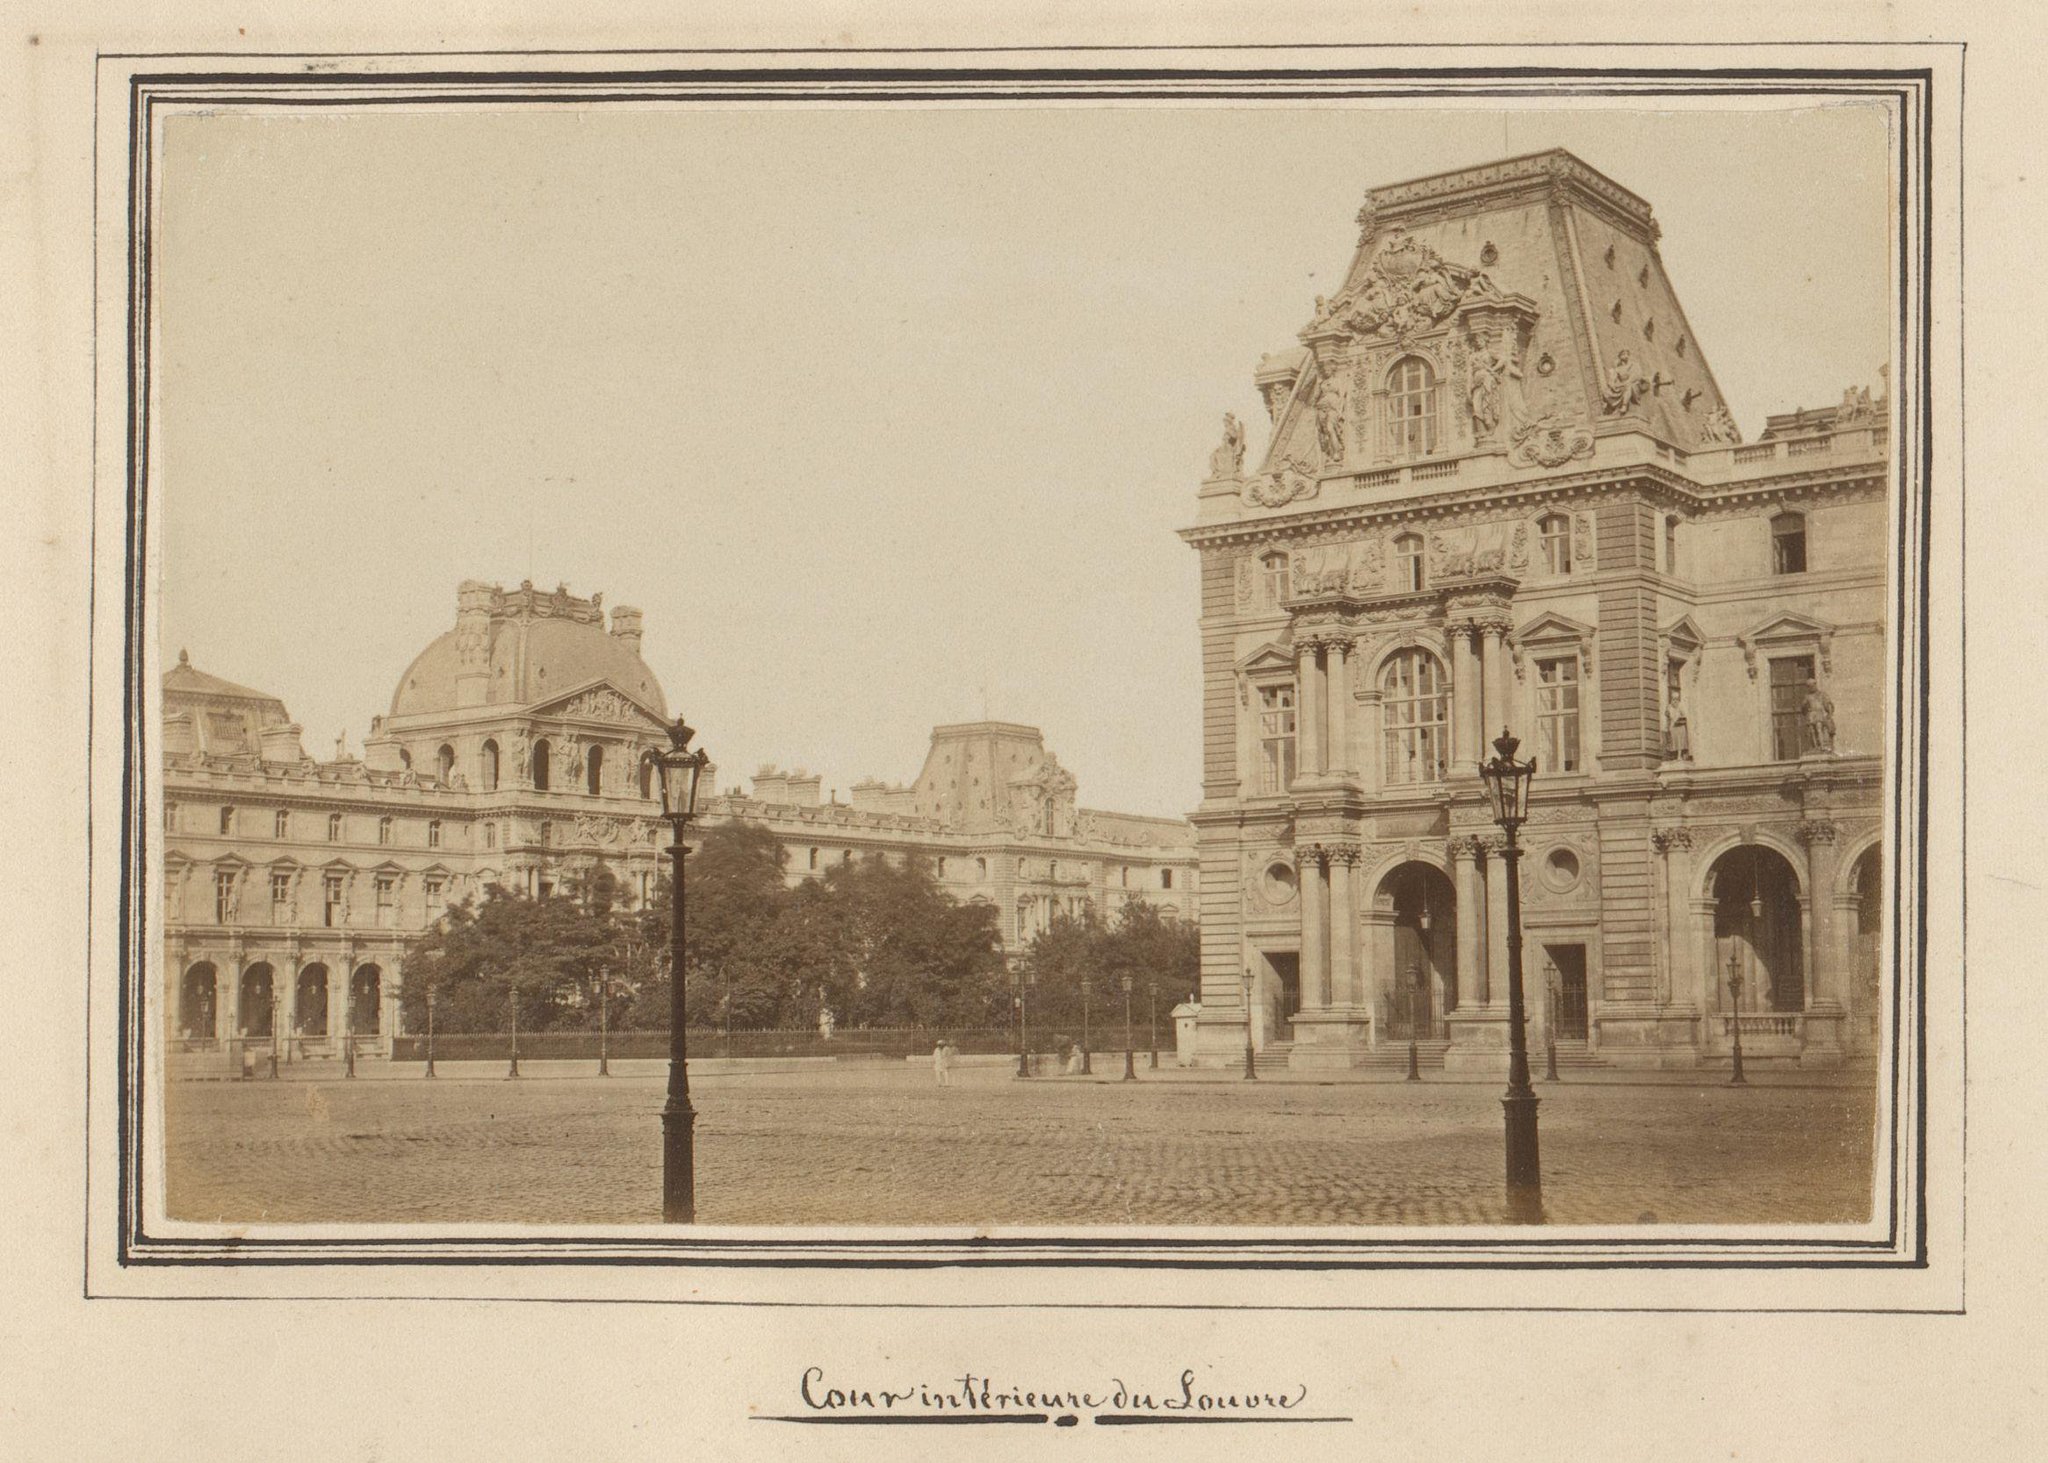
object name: photograph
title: Binnenplaats van het Louvre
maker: Anonymous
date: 1870-1890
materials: paper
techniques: albumen print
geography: paris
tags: façade of inner court